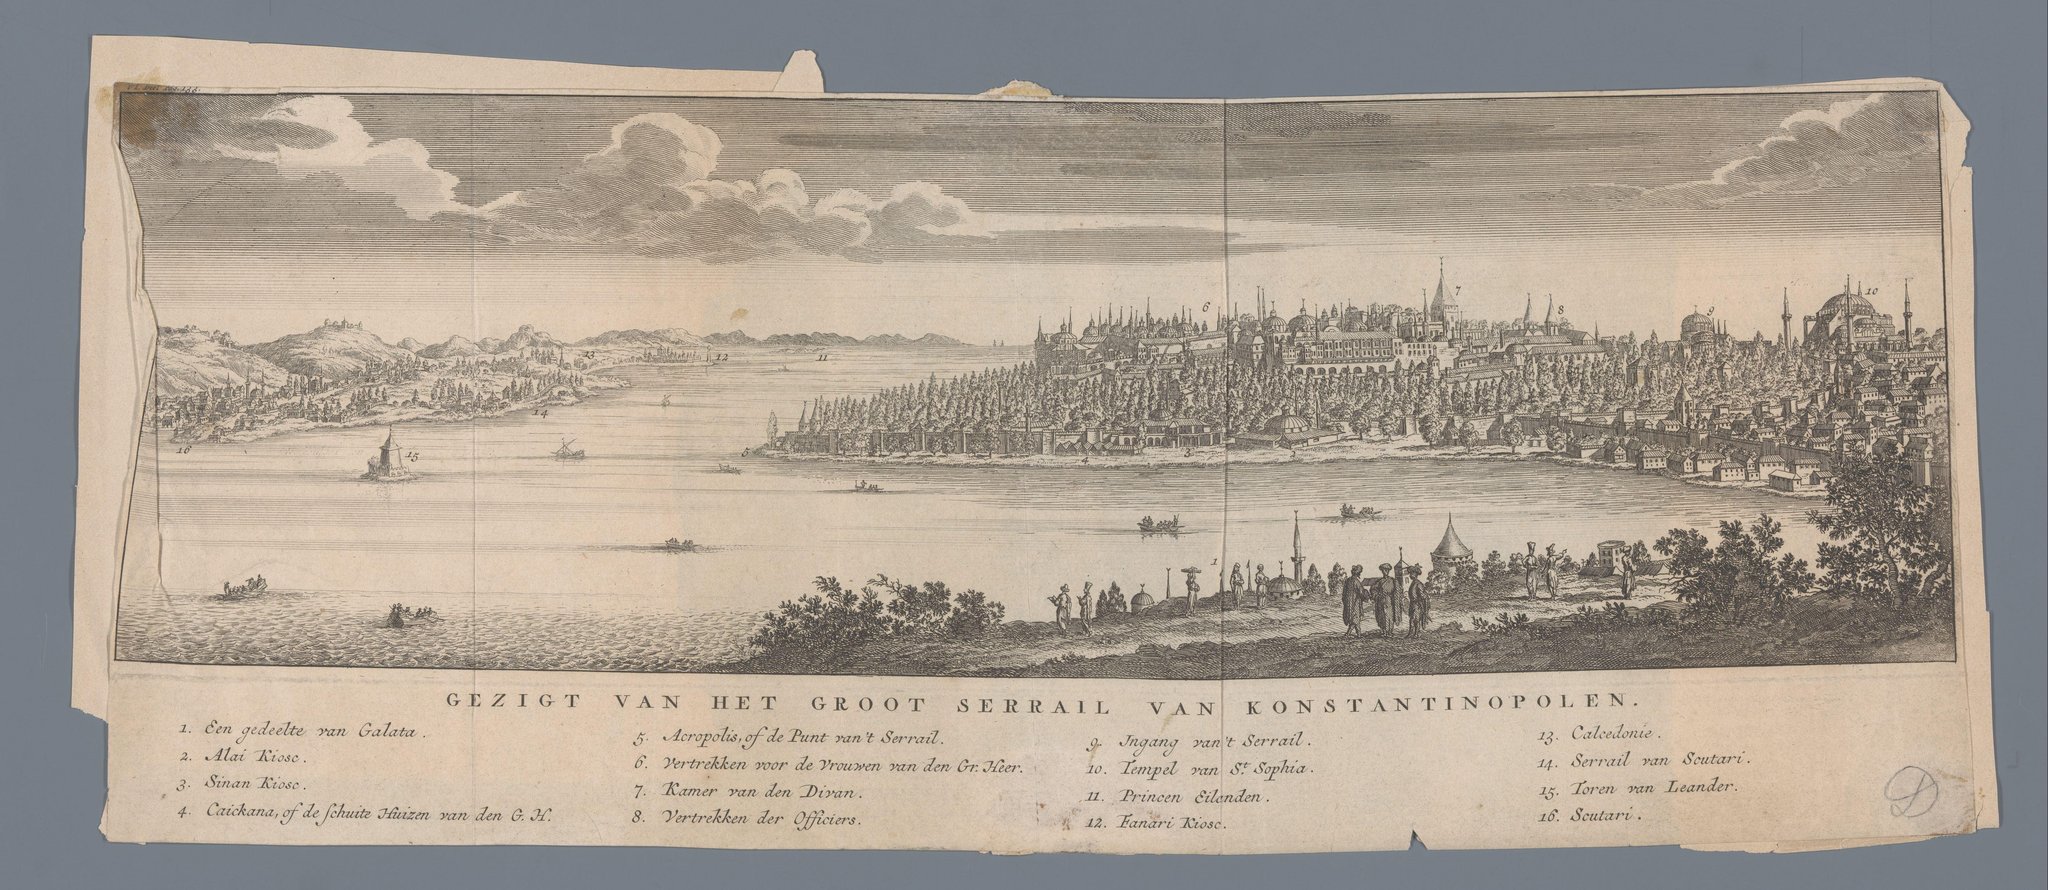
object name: print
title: Gezigt van het groot serrail van Konstantinopolen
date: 1683-1739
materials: paper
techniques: etching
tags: prospect of city, town panorama, silhouette of city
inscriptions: collector's mark: Lugt 2233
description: Gezicht op Constantinopel (Istanbul) met het paleis van de sultan. Onder de afbeelding staat een legenda met nummers. linksboven: "VI Deel. Pag. 133." Gezicht vanuit het noordwesten, staande in het stadsdeel Galata, op de akropolis met het Topkapi paleis. Uiterst rechts de tot moskee omgebouwde Hagia Sophia.